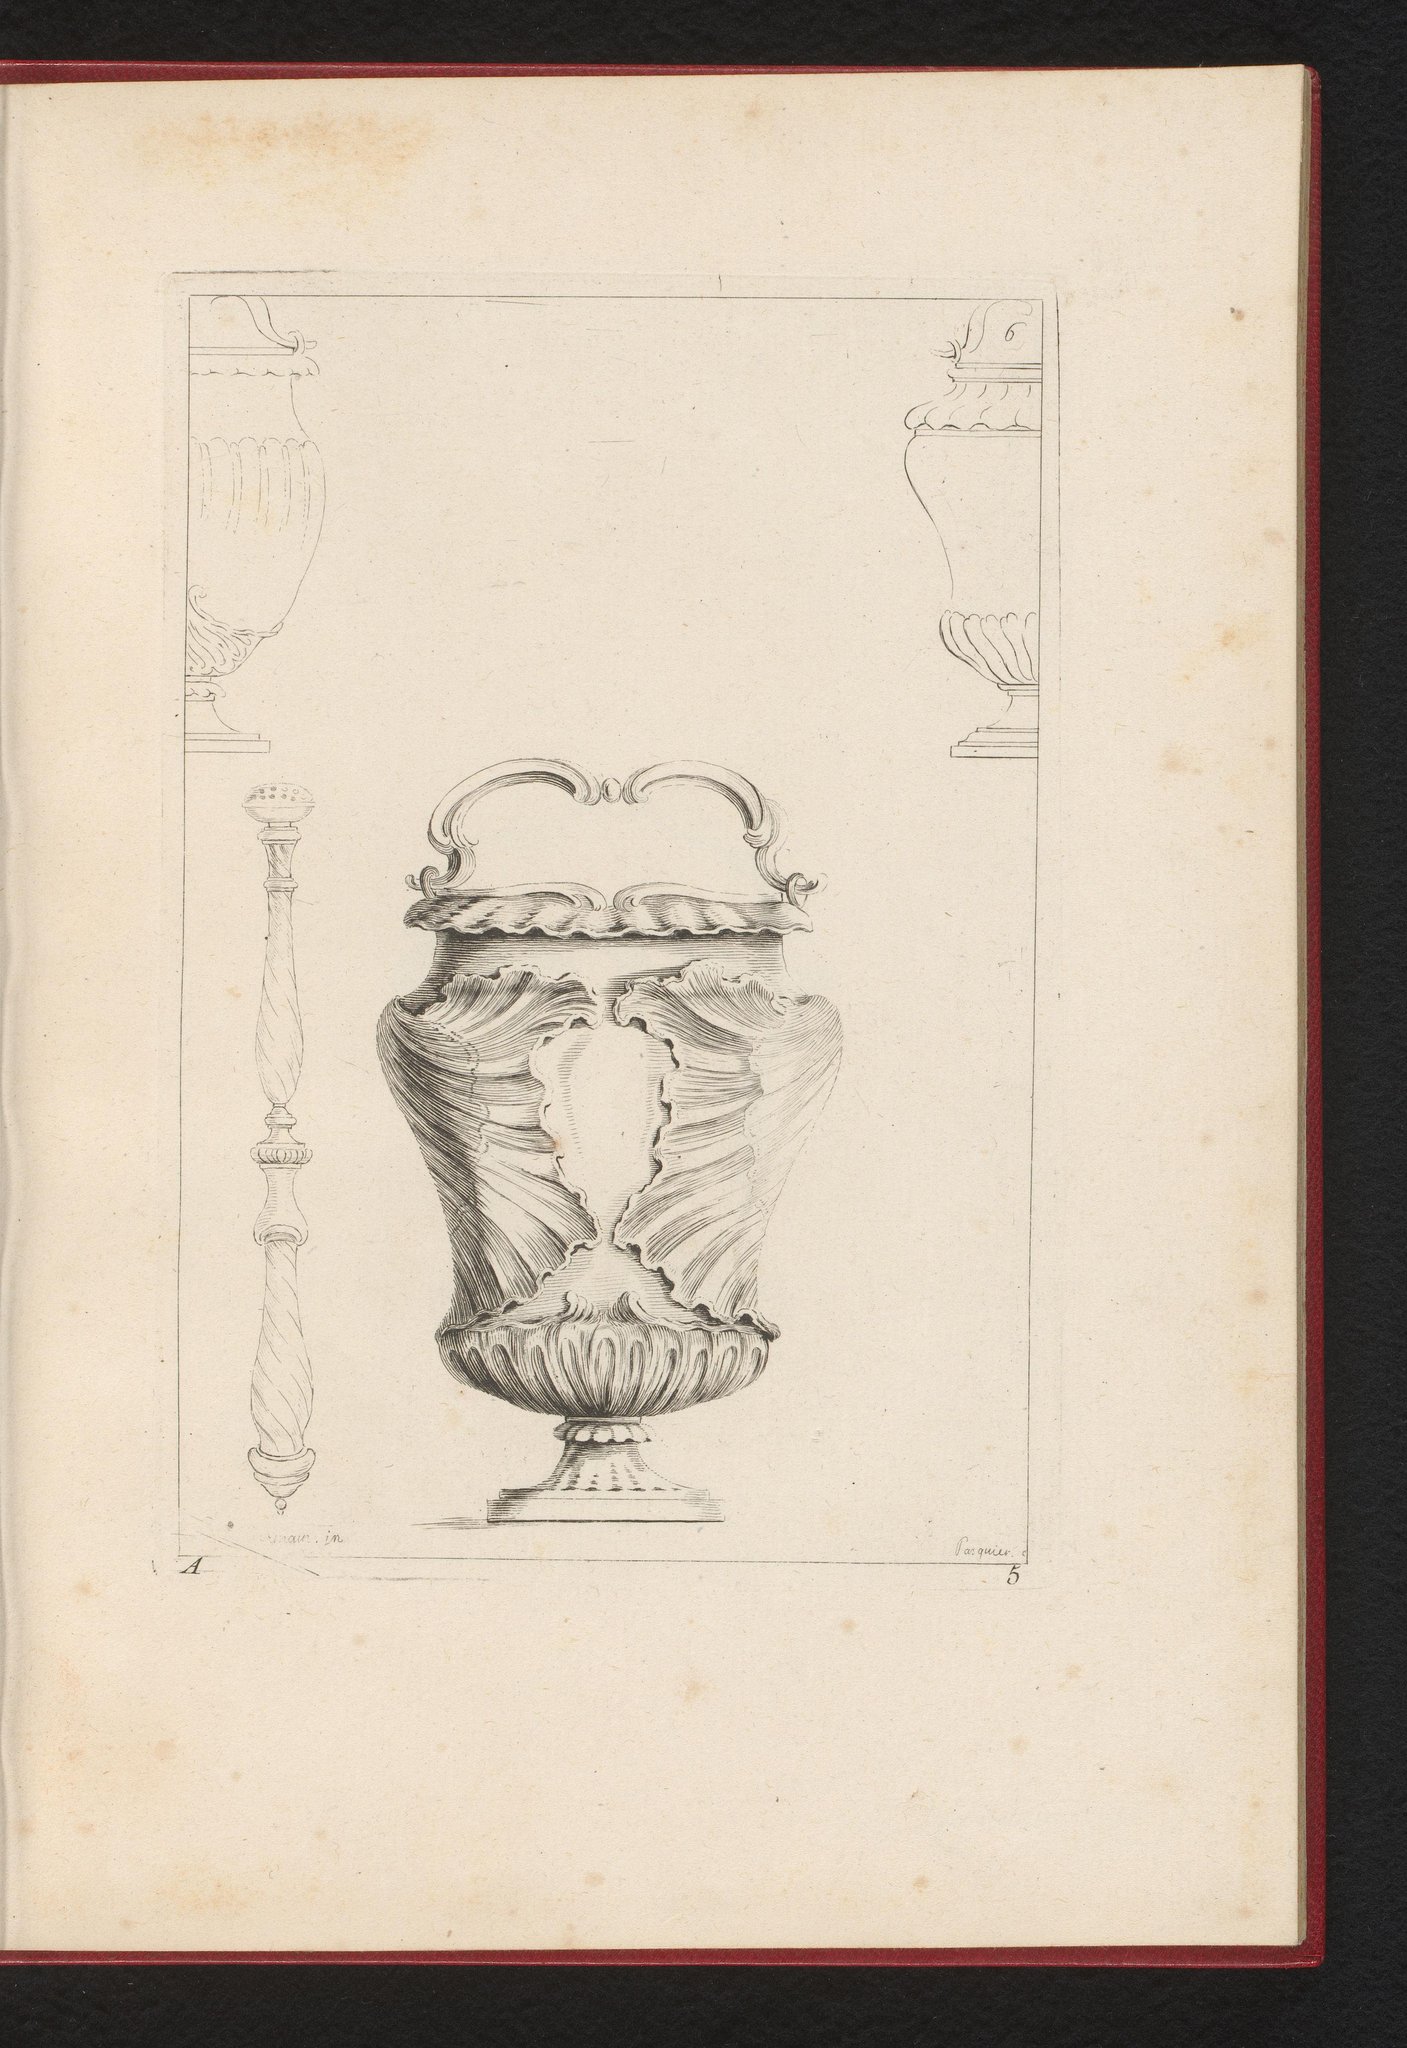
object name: print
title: Elements d'orfevrerie divisés en deux parties de cinquante feuilles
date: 1748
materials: paper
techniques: etching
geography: paris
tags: ornaments ~ art, vessels and utensils used in the church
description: Een aantal van de objecten in deze reeks heeft een eigen ondertitel, die verwijst naar genummerde 'cahiers' (afleveringen) waarin de prenten werden uitgegeven. Het is onduidelijk welke objecten recies bij welke aflevering horen. Daarom is die ondertitel enkel verwerkt bij de prent waarop die voorkomt.